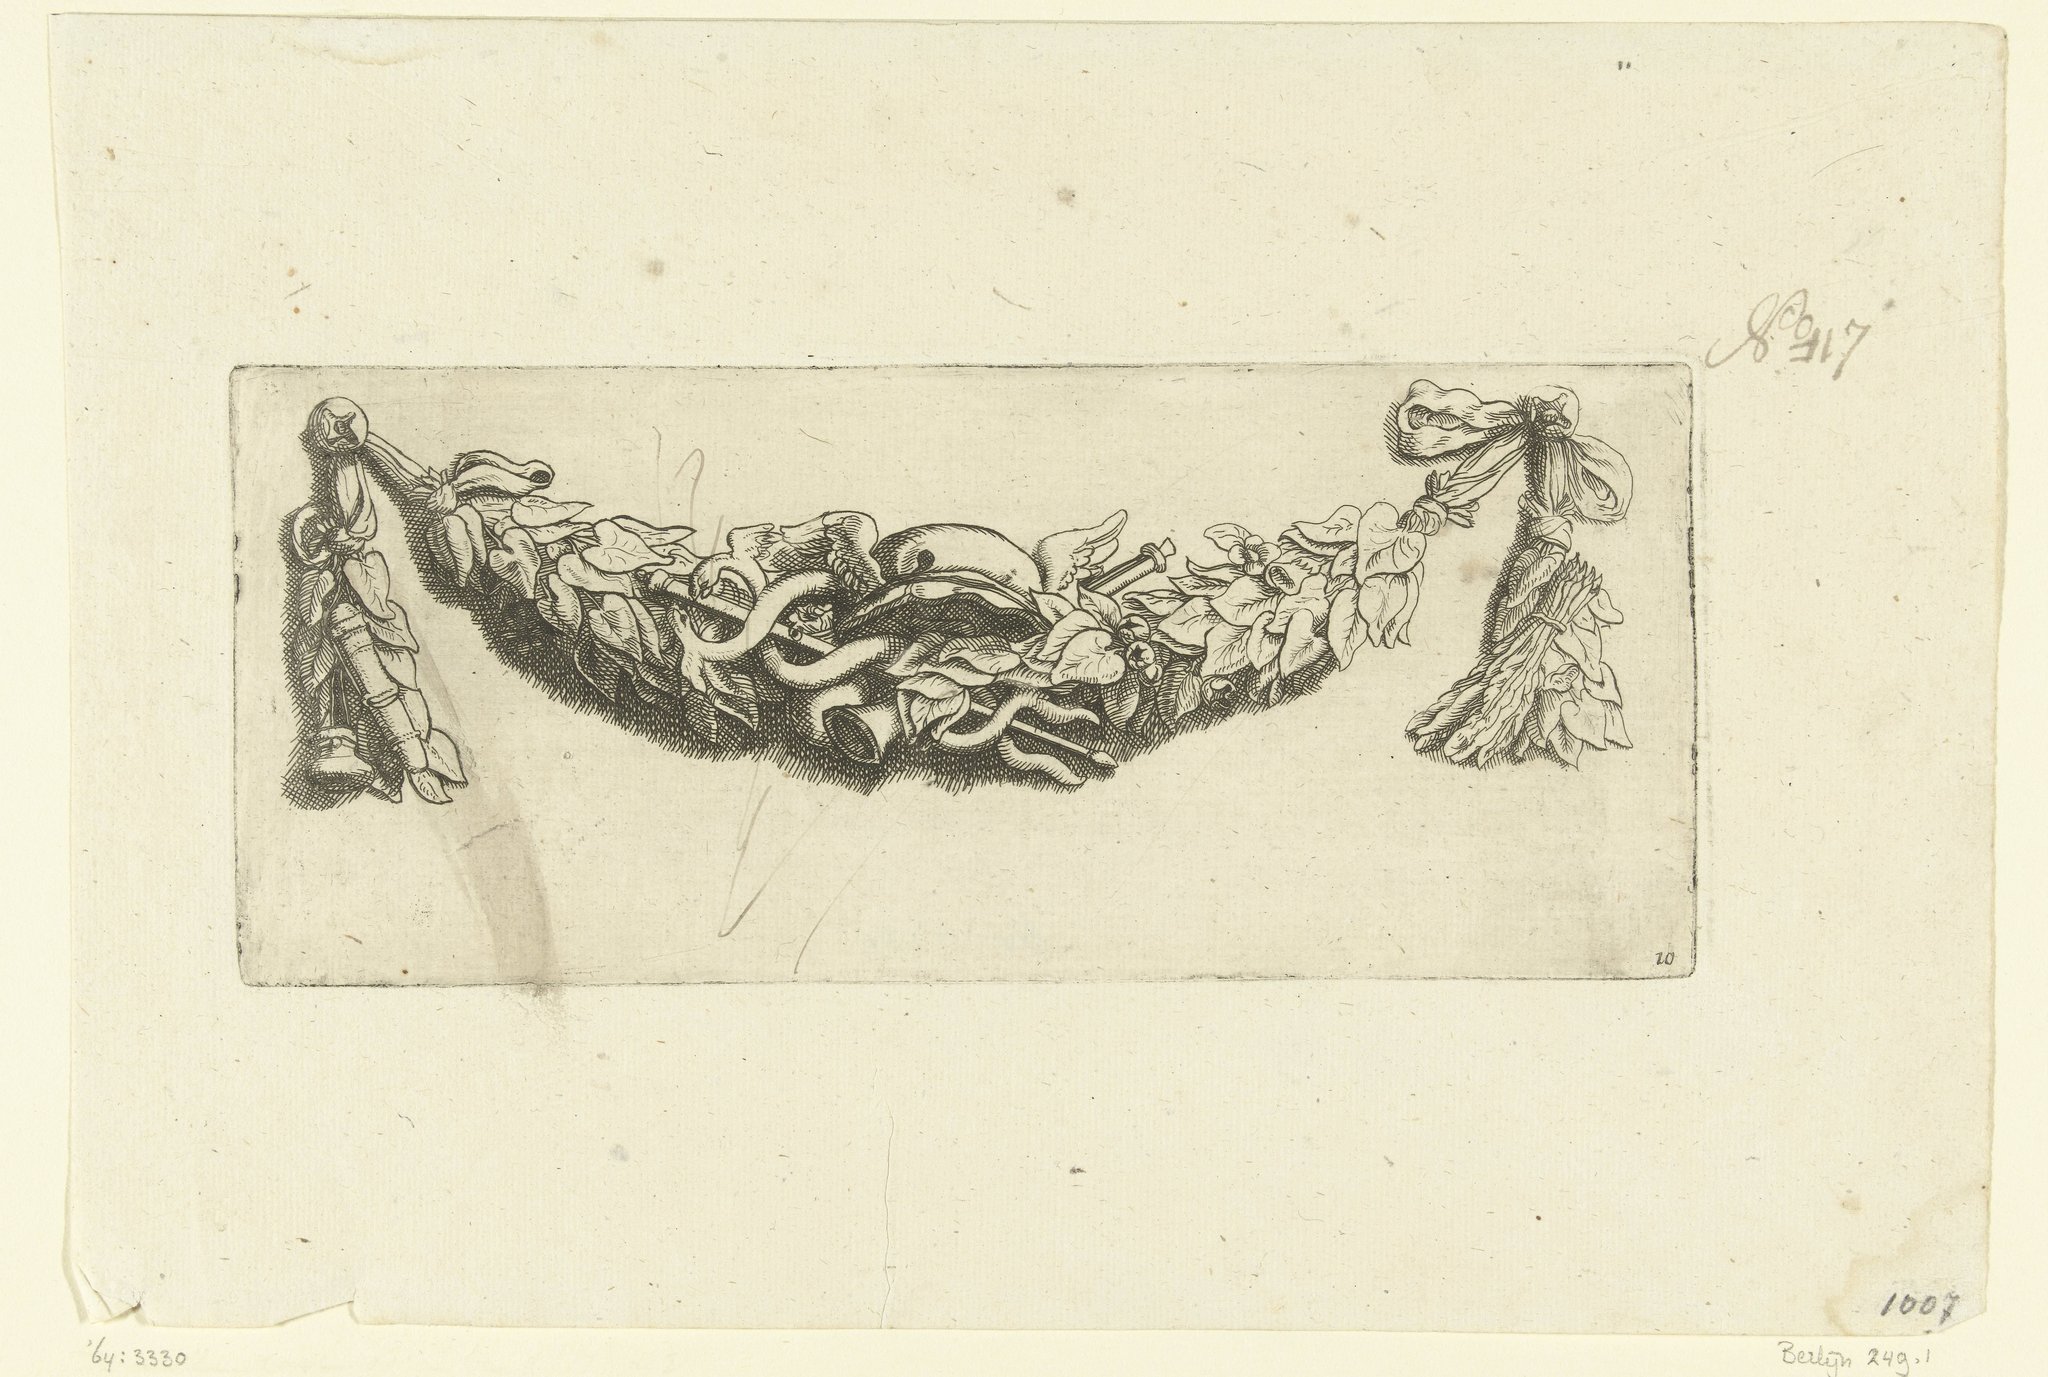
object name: ornament print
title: Aerdighe Festonnen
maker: Anonymous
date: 1665-1700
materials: paper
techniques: etching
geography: amsterdam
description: Kopie naar festoenen uit de serie Prima Pars Praecipuarum.../ Het Eerste Deel Van de voornaemste Statuen ende Cieraten.../ La Premier Partie....